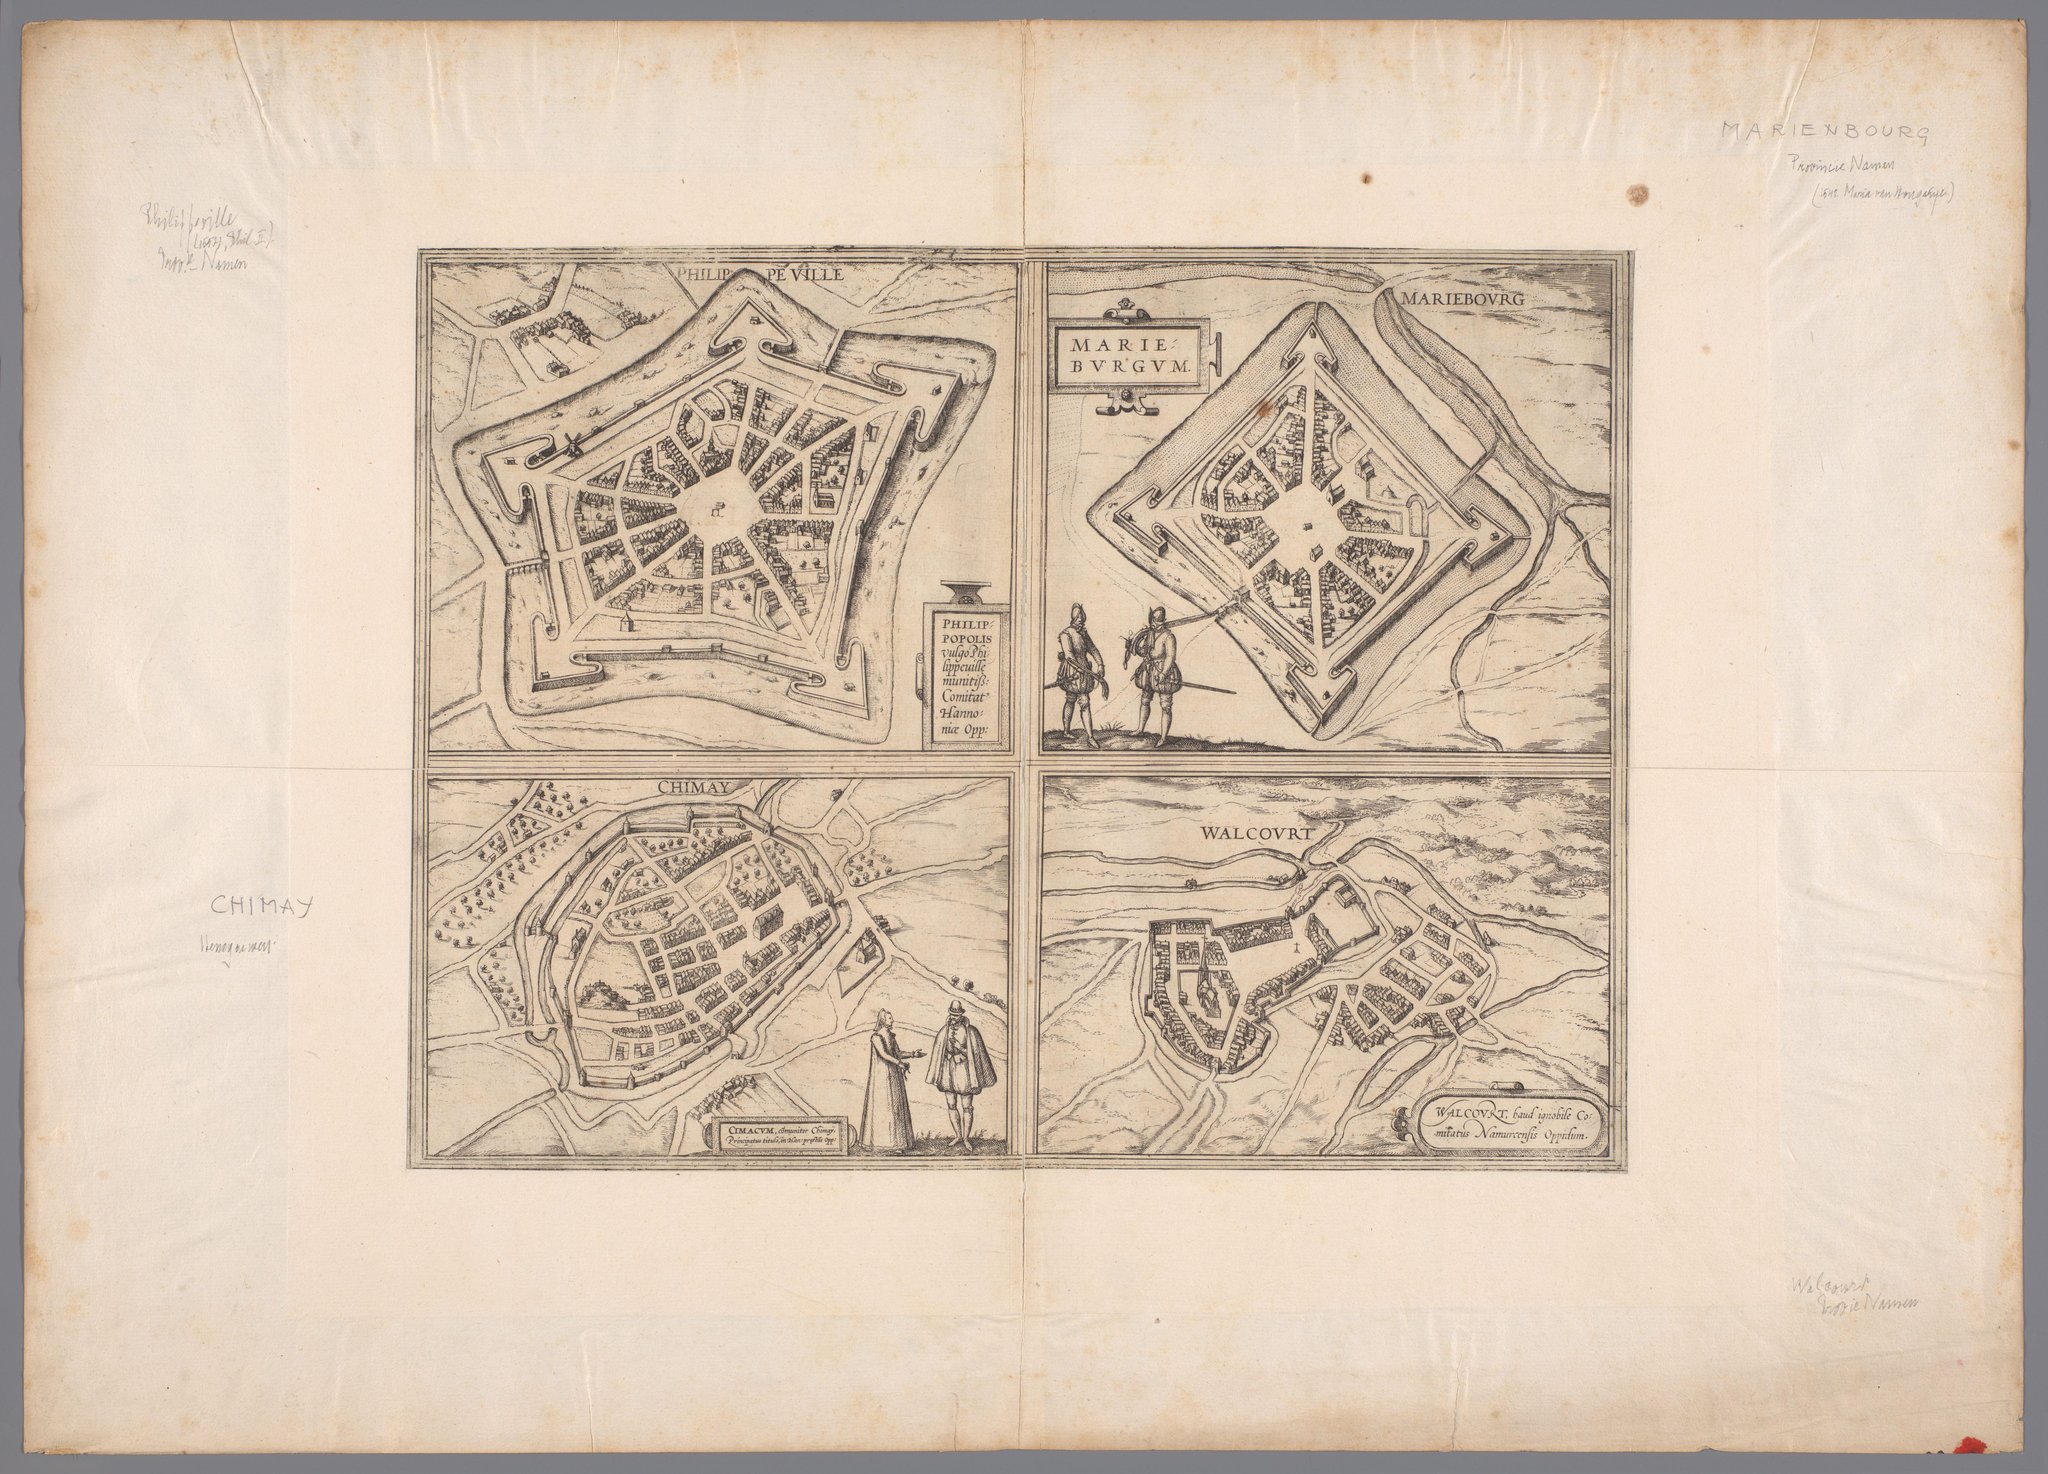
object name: print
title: Philippeville / Mariebourg / Chimay / Walcourt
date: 1581-1657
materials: paper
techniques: etching, letterpress printing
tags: maps of cities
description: Prent uit: Civitates orbis terrarum. Amsterdam: Braun en Hogenberg, 1581. Of uit: Theatrum urbium celebriorum totius Belgii. 2 dln. Amsterdam: Johannes Janssonius, 1657.